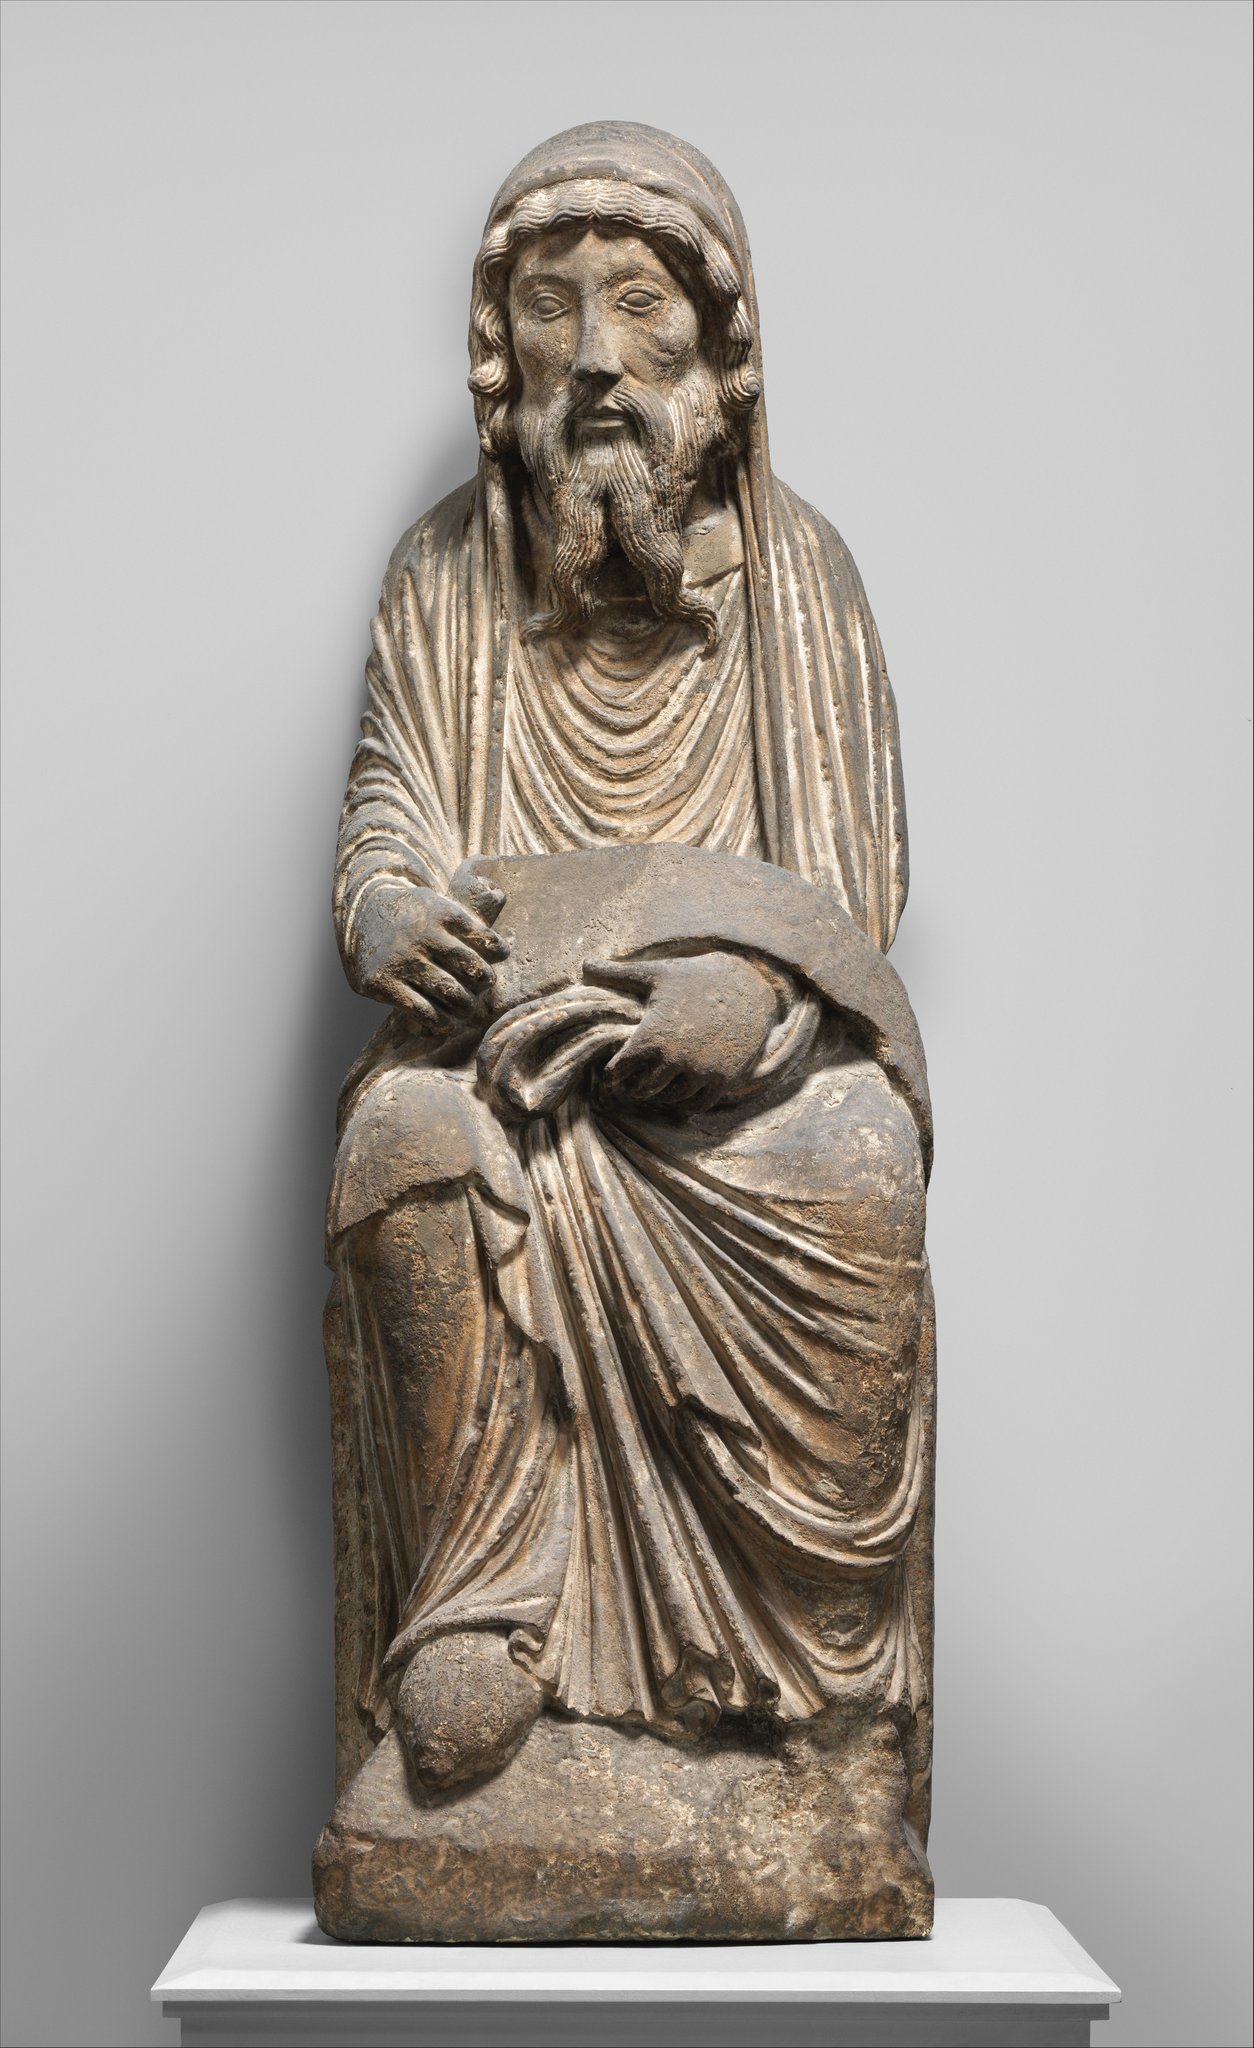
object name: sculpture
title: The Priest Aaron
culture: french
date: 1170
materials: limestone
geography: noyon